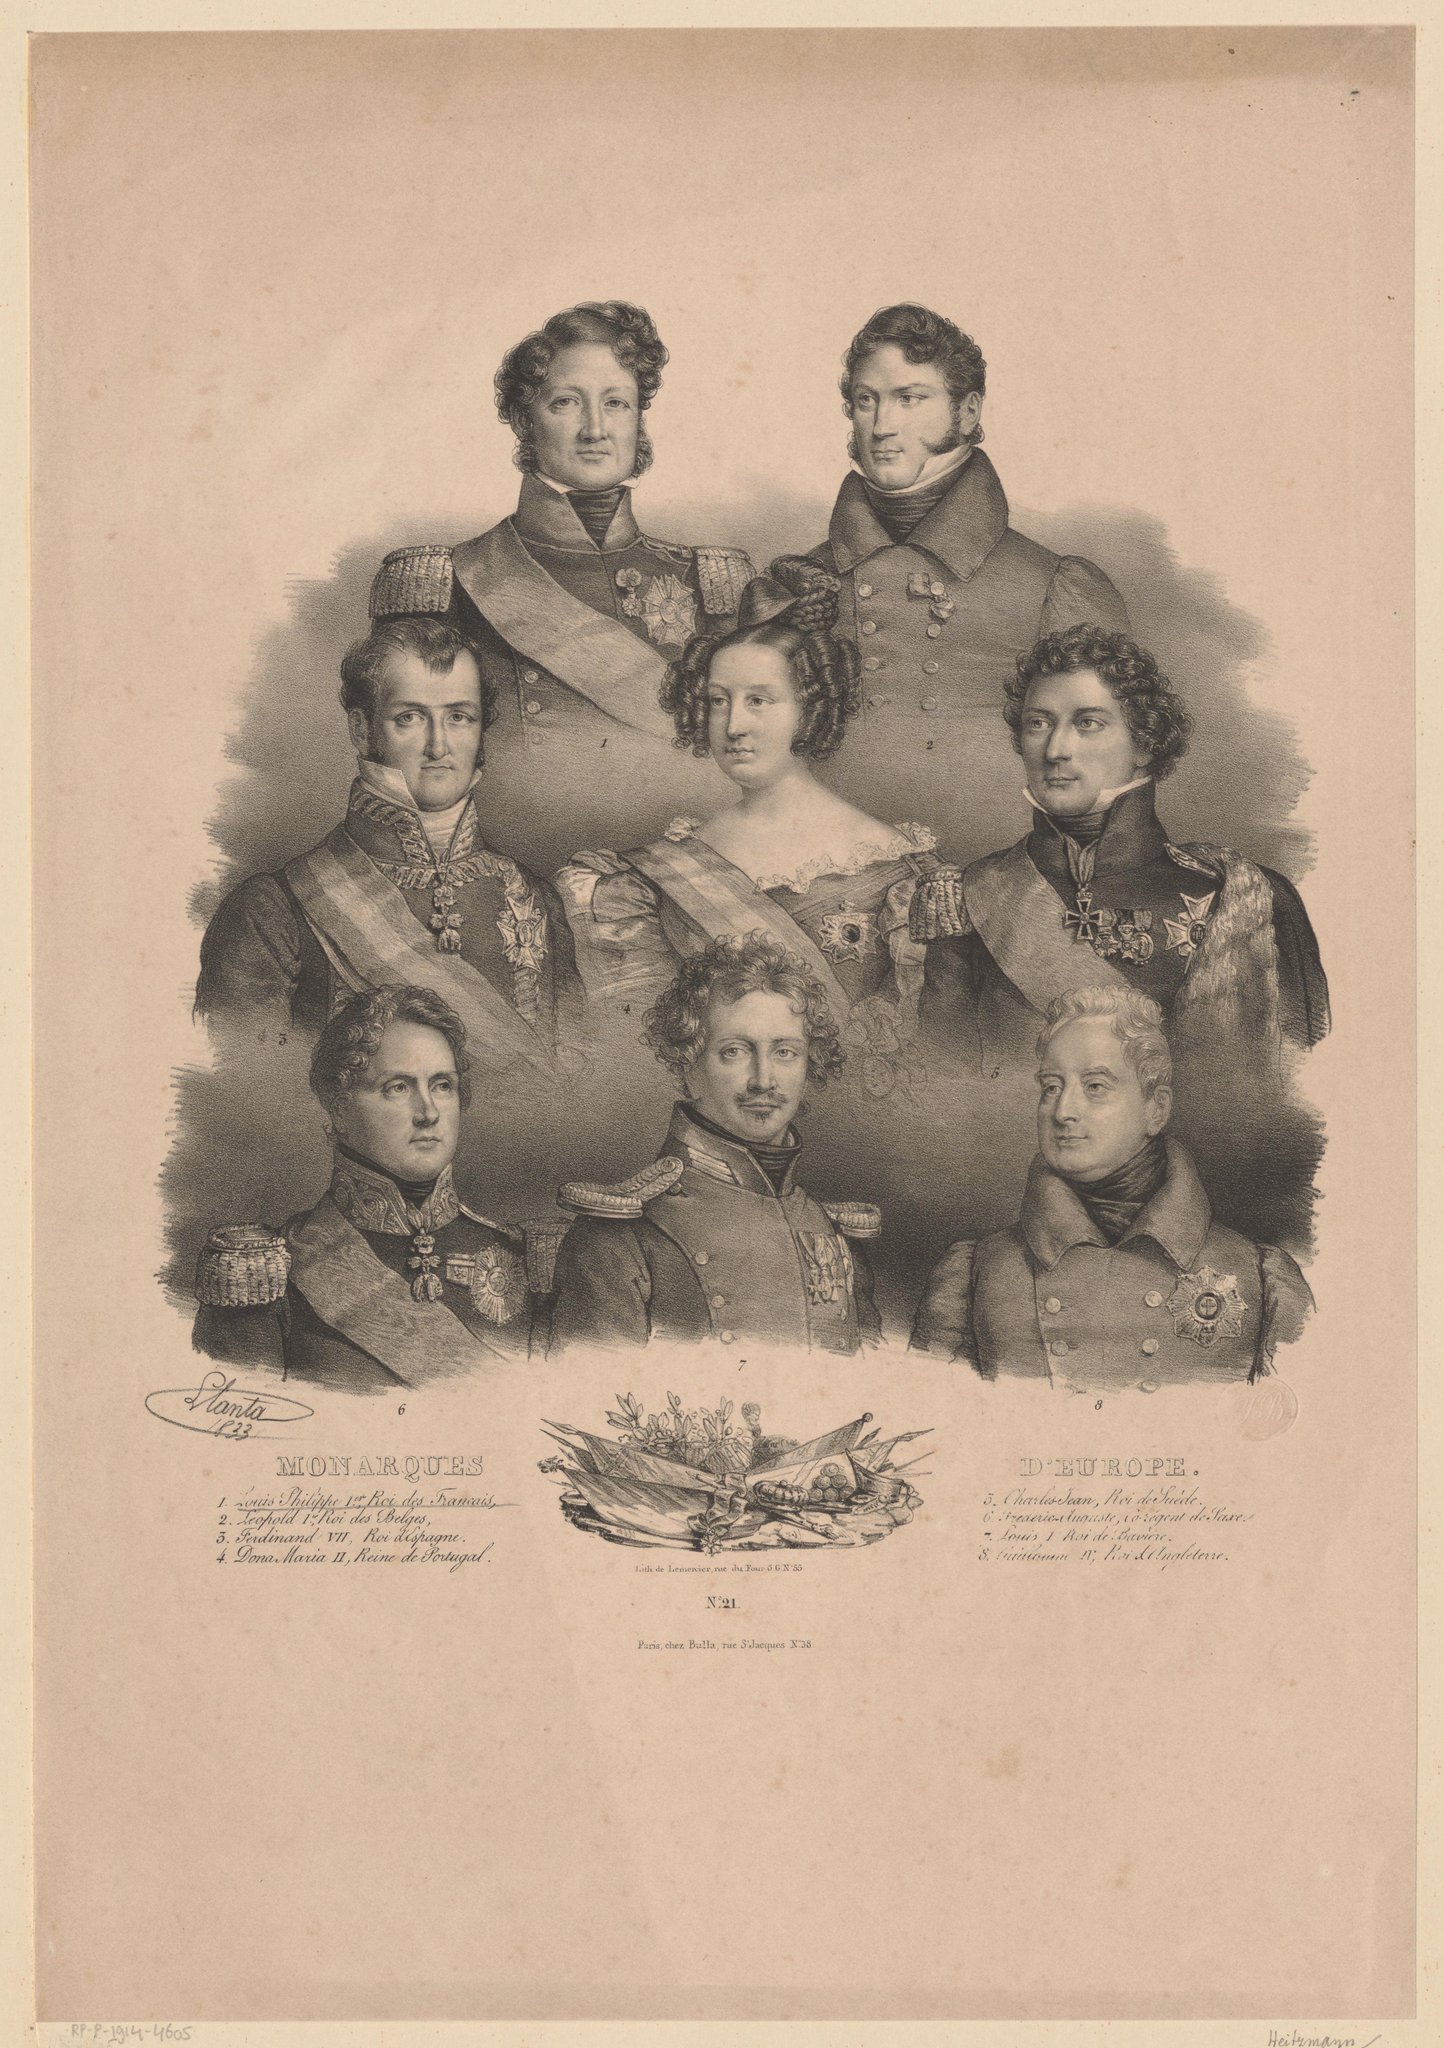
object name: print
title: Portretten van beroemde personen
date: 1833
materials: paper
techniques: lithograph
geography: paris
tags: frederik august i (koning van saksen), ferdinand vii (koning van spanje), lodewijk i (koning van beieren), laeken, leopold i (koning der belgen), lodewijk filips i (koning van frankrijk), london, willem iv hendrik (koning van het verenigd koninkrijk en hannover), historical persons, queen, king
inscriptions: : Lugt 4088, collector's mark: Lugt 2228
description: Portretten van Lodewijk Filips I, koning van Frankrijk, Leopold I, koning der Belgen, Ferdinand VII, koning van Spanje, Maria II van Portugal, Karel XIV Johan, koning van Zweden en Noorwegen, Frederik August I, koning van Saksen, Lodewijk I, koning van Beieren en Willem IV Hendrik, koning van Groot-Brittannië en Hannover.